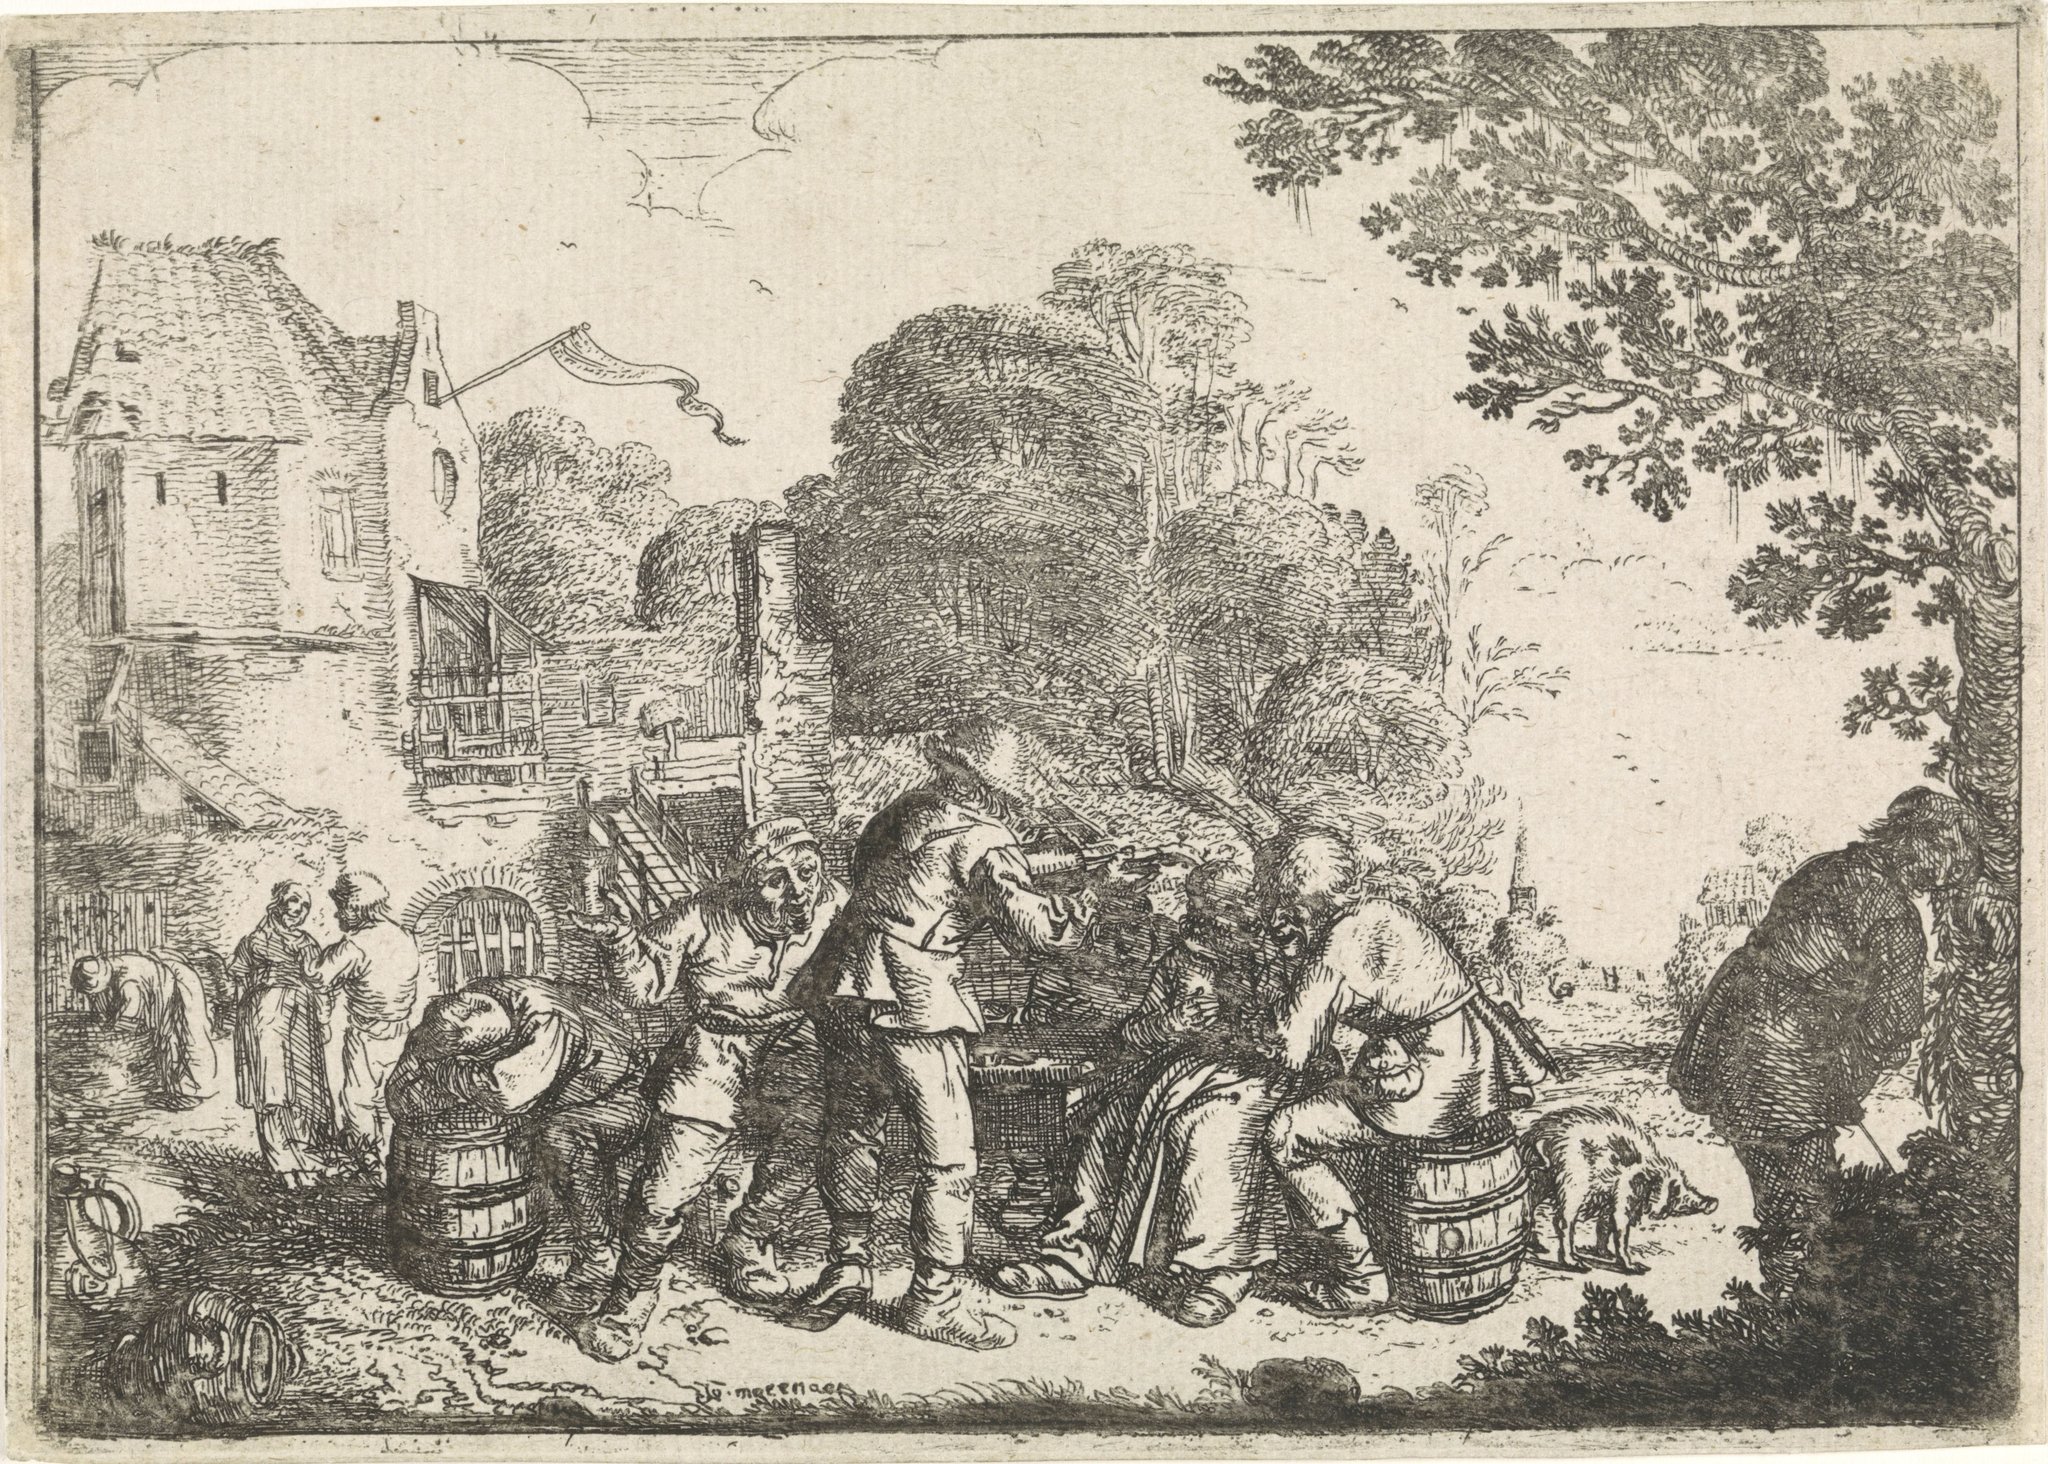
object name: print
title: Boerenfeest met mandolinespeler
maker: jan miense molenaer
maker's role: draughtsman, painter, print maker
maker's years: 1609-1668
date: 1619-1668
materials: paper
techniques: etching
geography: netherlands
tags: farmers, sleeping; unconsciousness, cithern, mandolin, guitar, balalaika, urination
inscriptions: collector's mark: Lugt 2165, collector's mark: Lugt 2228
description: Een boerengezelschap met in het midden, op de rug gezien, een mandolinespeler. Links een slapende man en een man, die zijn beker heft. Rechts urineert een man tegen een boom. Op de achtergrond een woning met een wimpel.